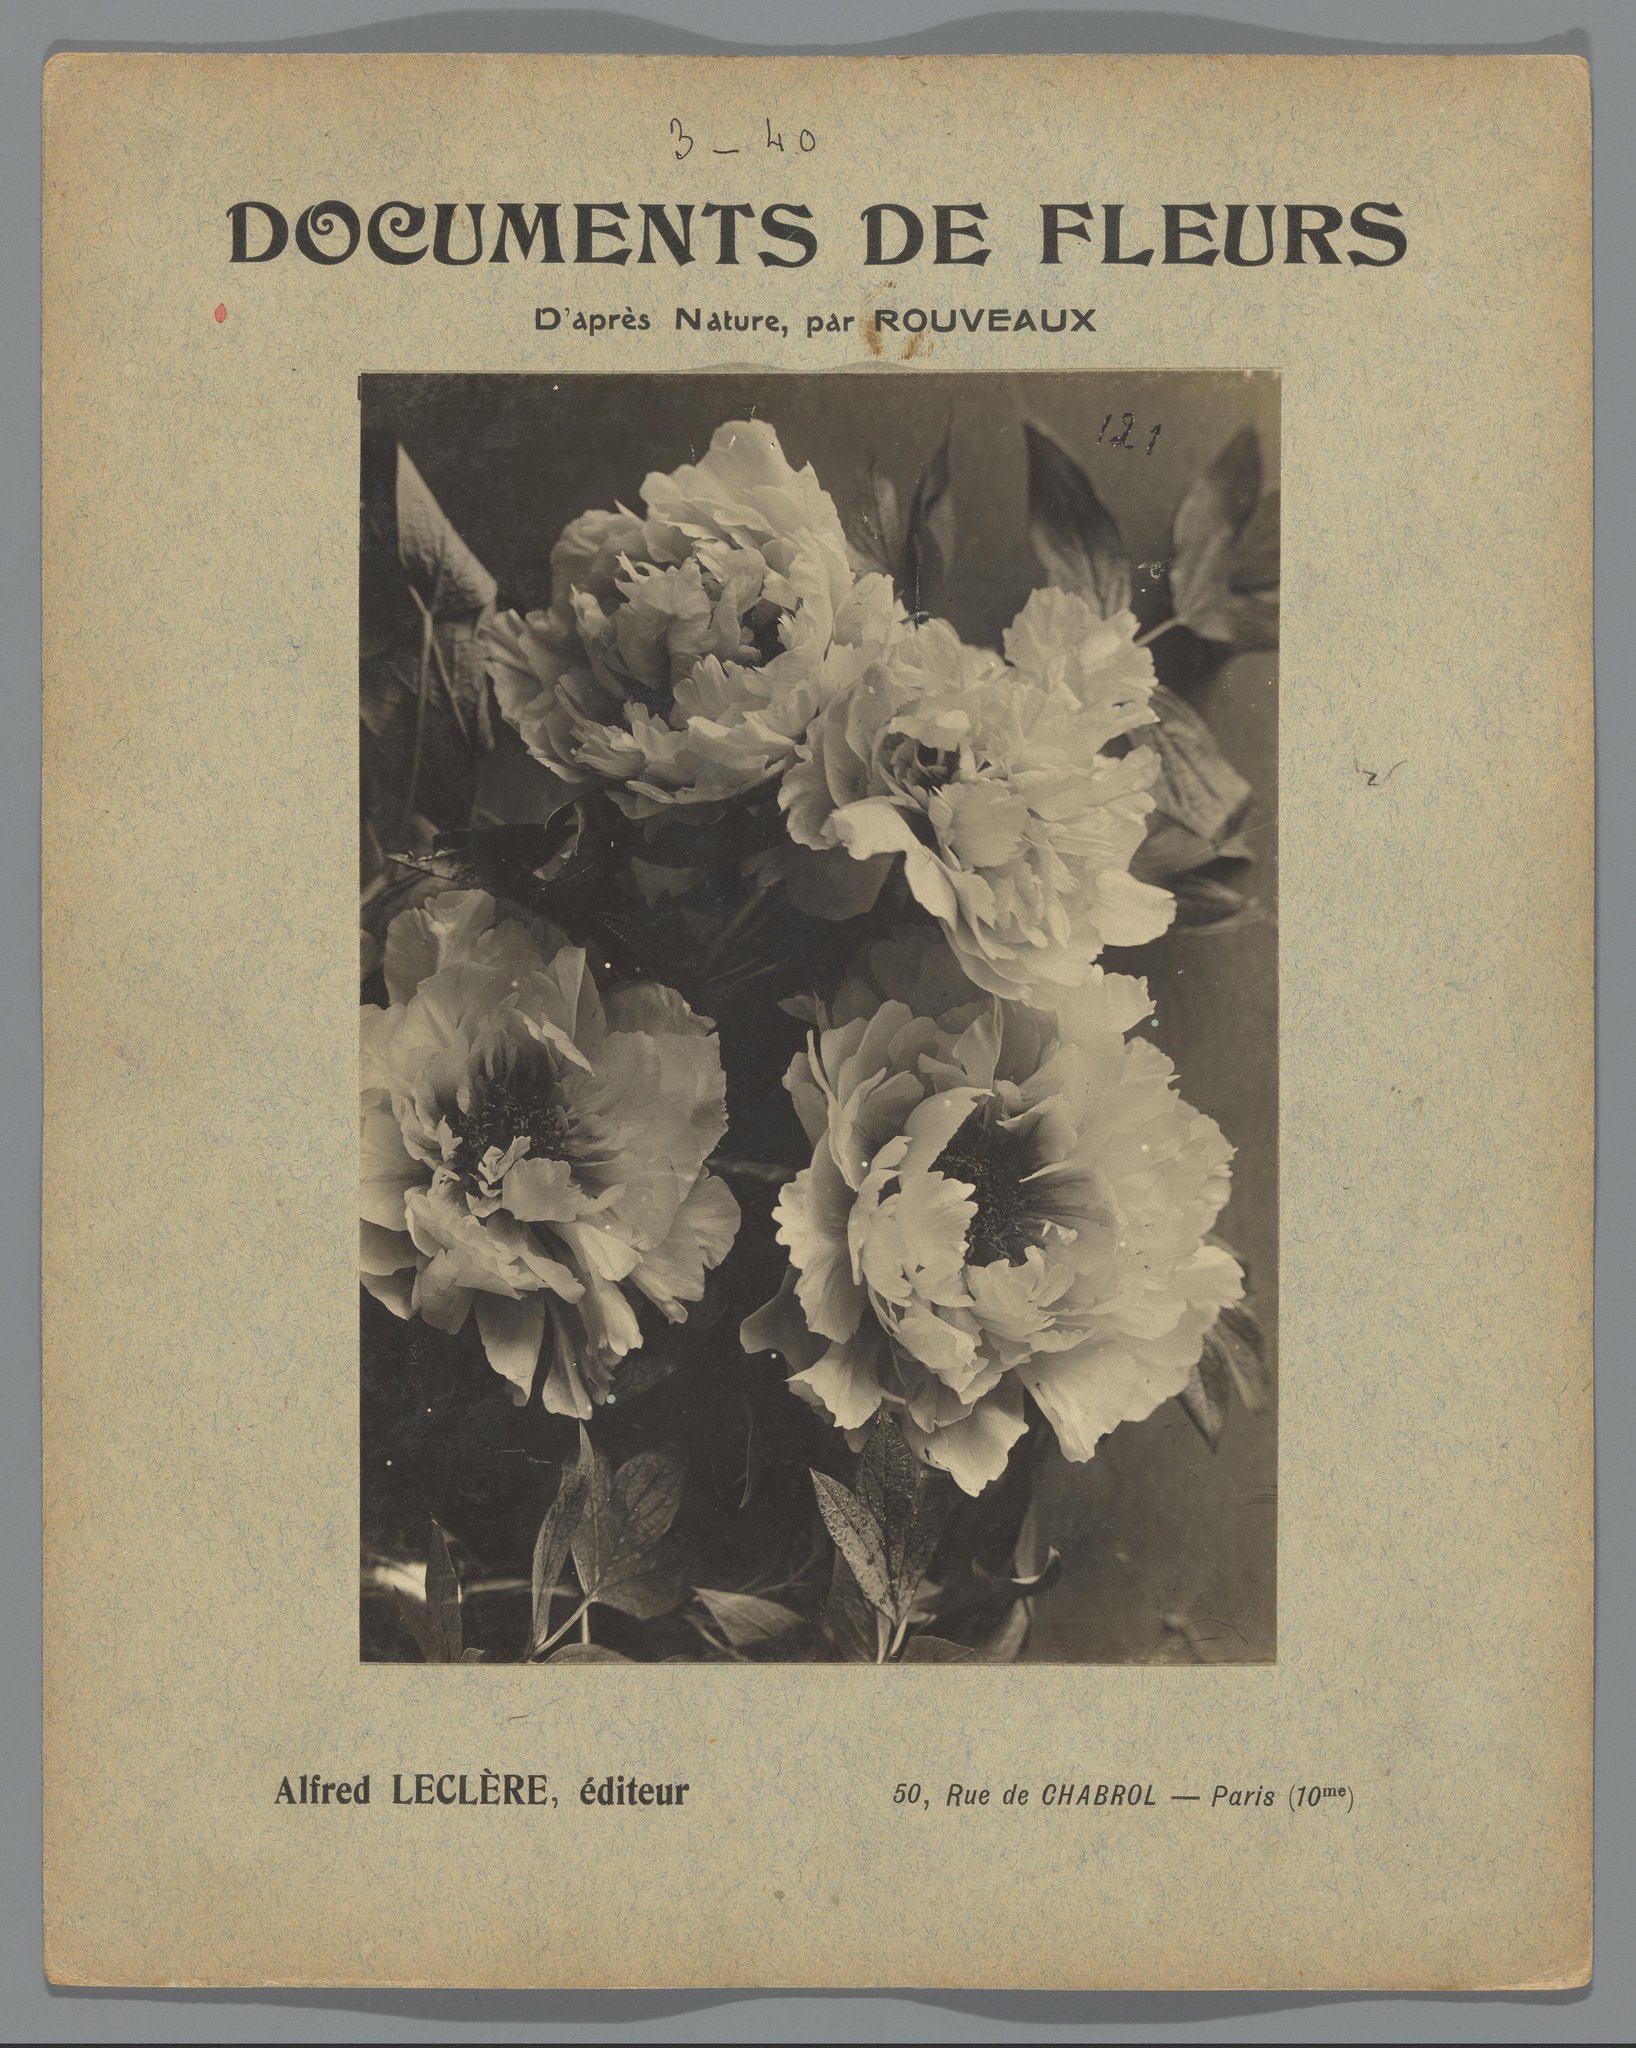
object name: photograph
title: Bloemstudie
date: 1895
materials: photographic support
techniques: gelatin silver print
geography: france